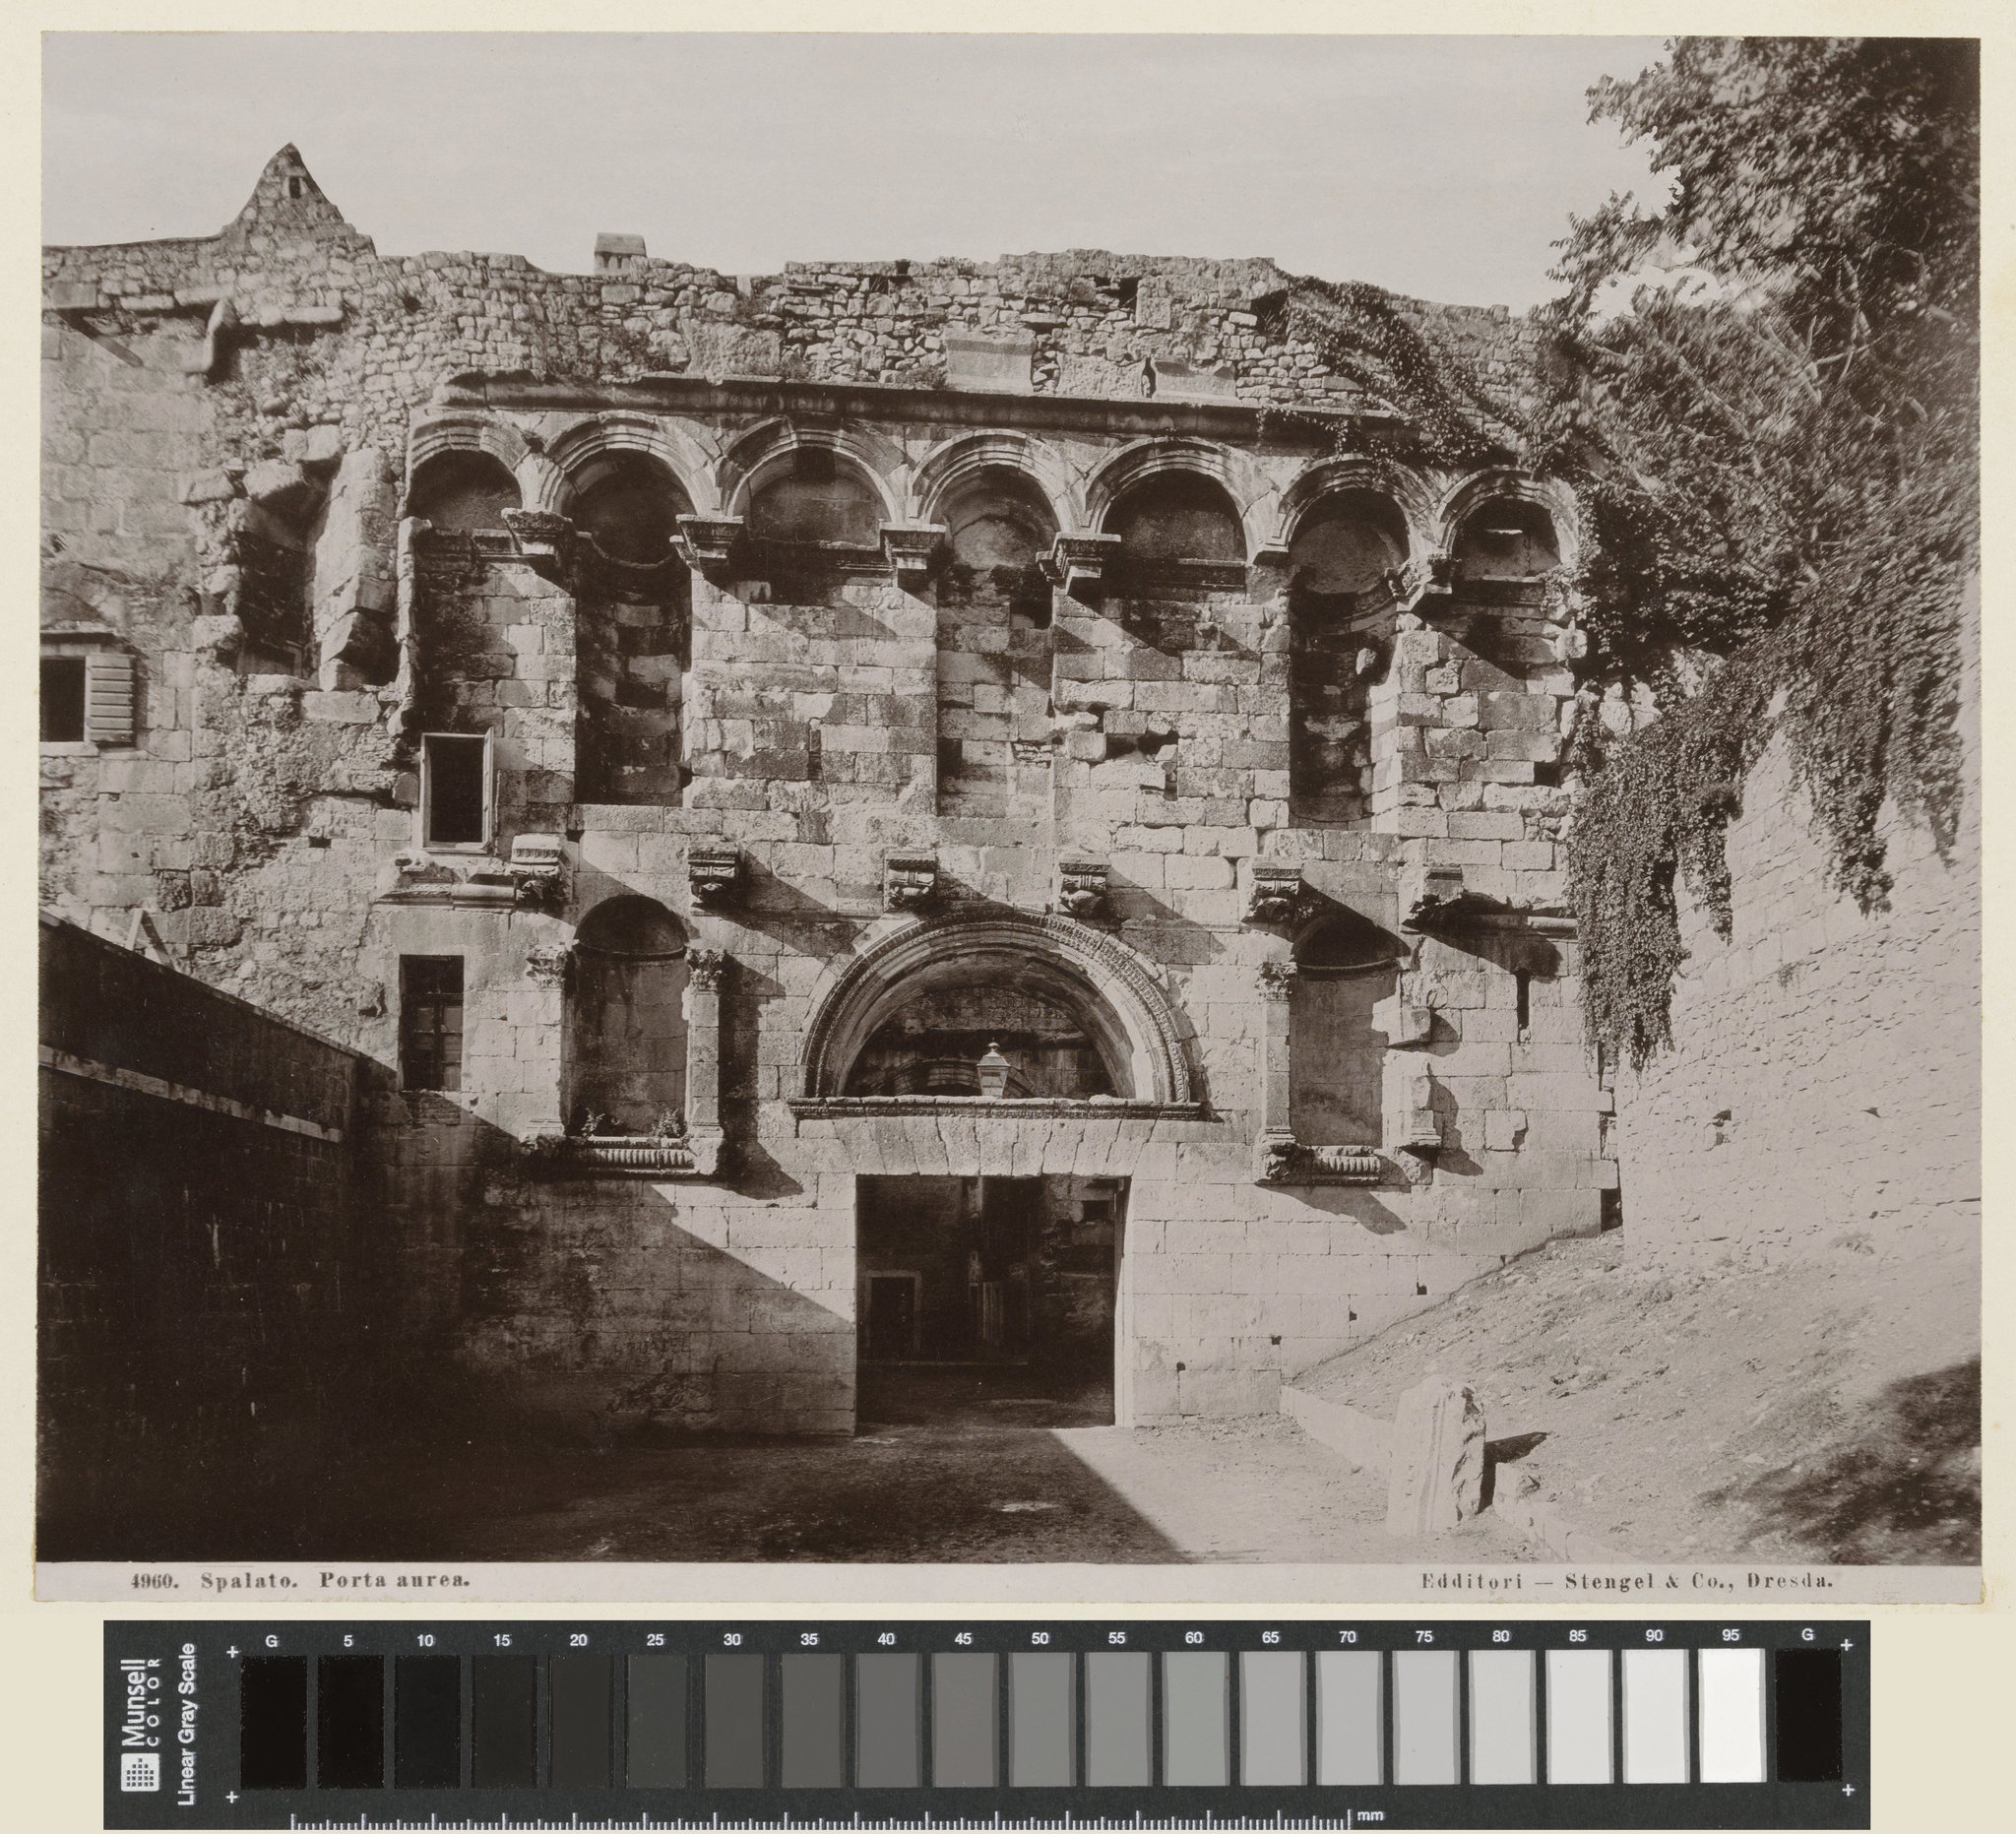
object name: photomechanical print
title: Gouden Poort van het Paleis van Diocletianus in Split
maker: Anonymous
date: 1889-1910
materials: cardboard, paper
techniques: photograph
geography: split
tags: ruin of a building ~ architecture, gate, entrance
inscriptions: collector's mark: Lugt 2228, title: ‘4960. Spalato. Porta aurea. Edditori - Stengel & Co., Dresda.’